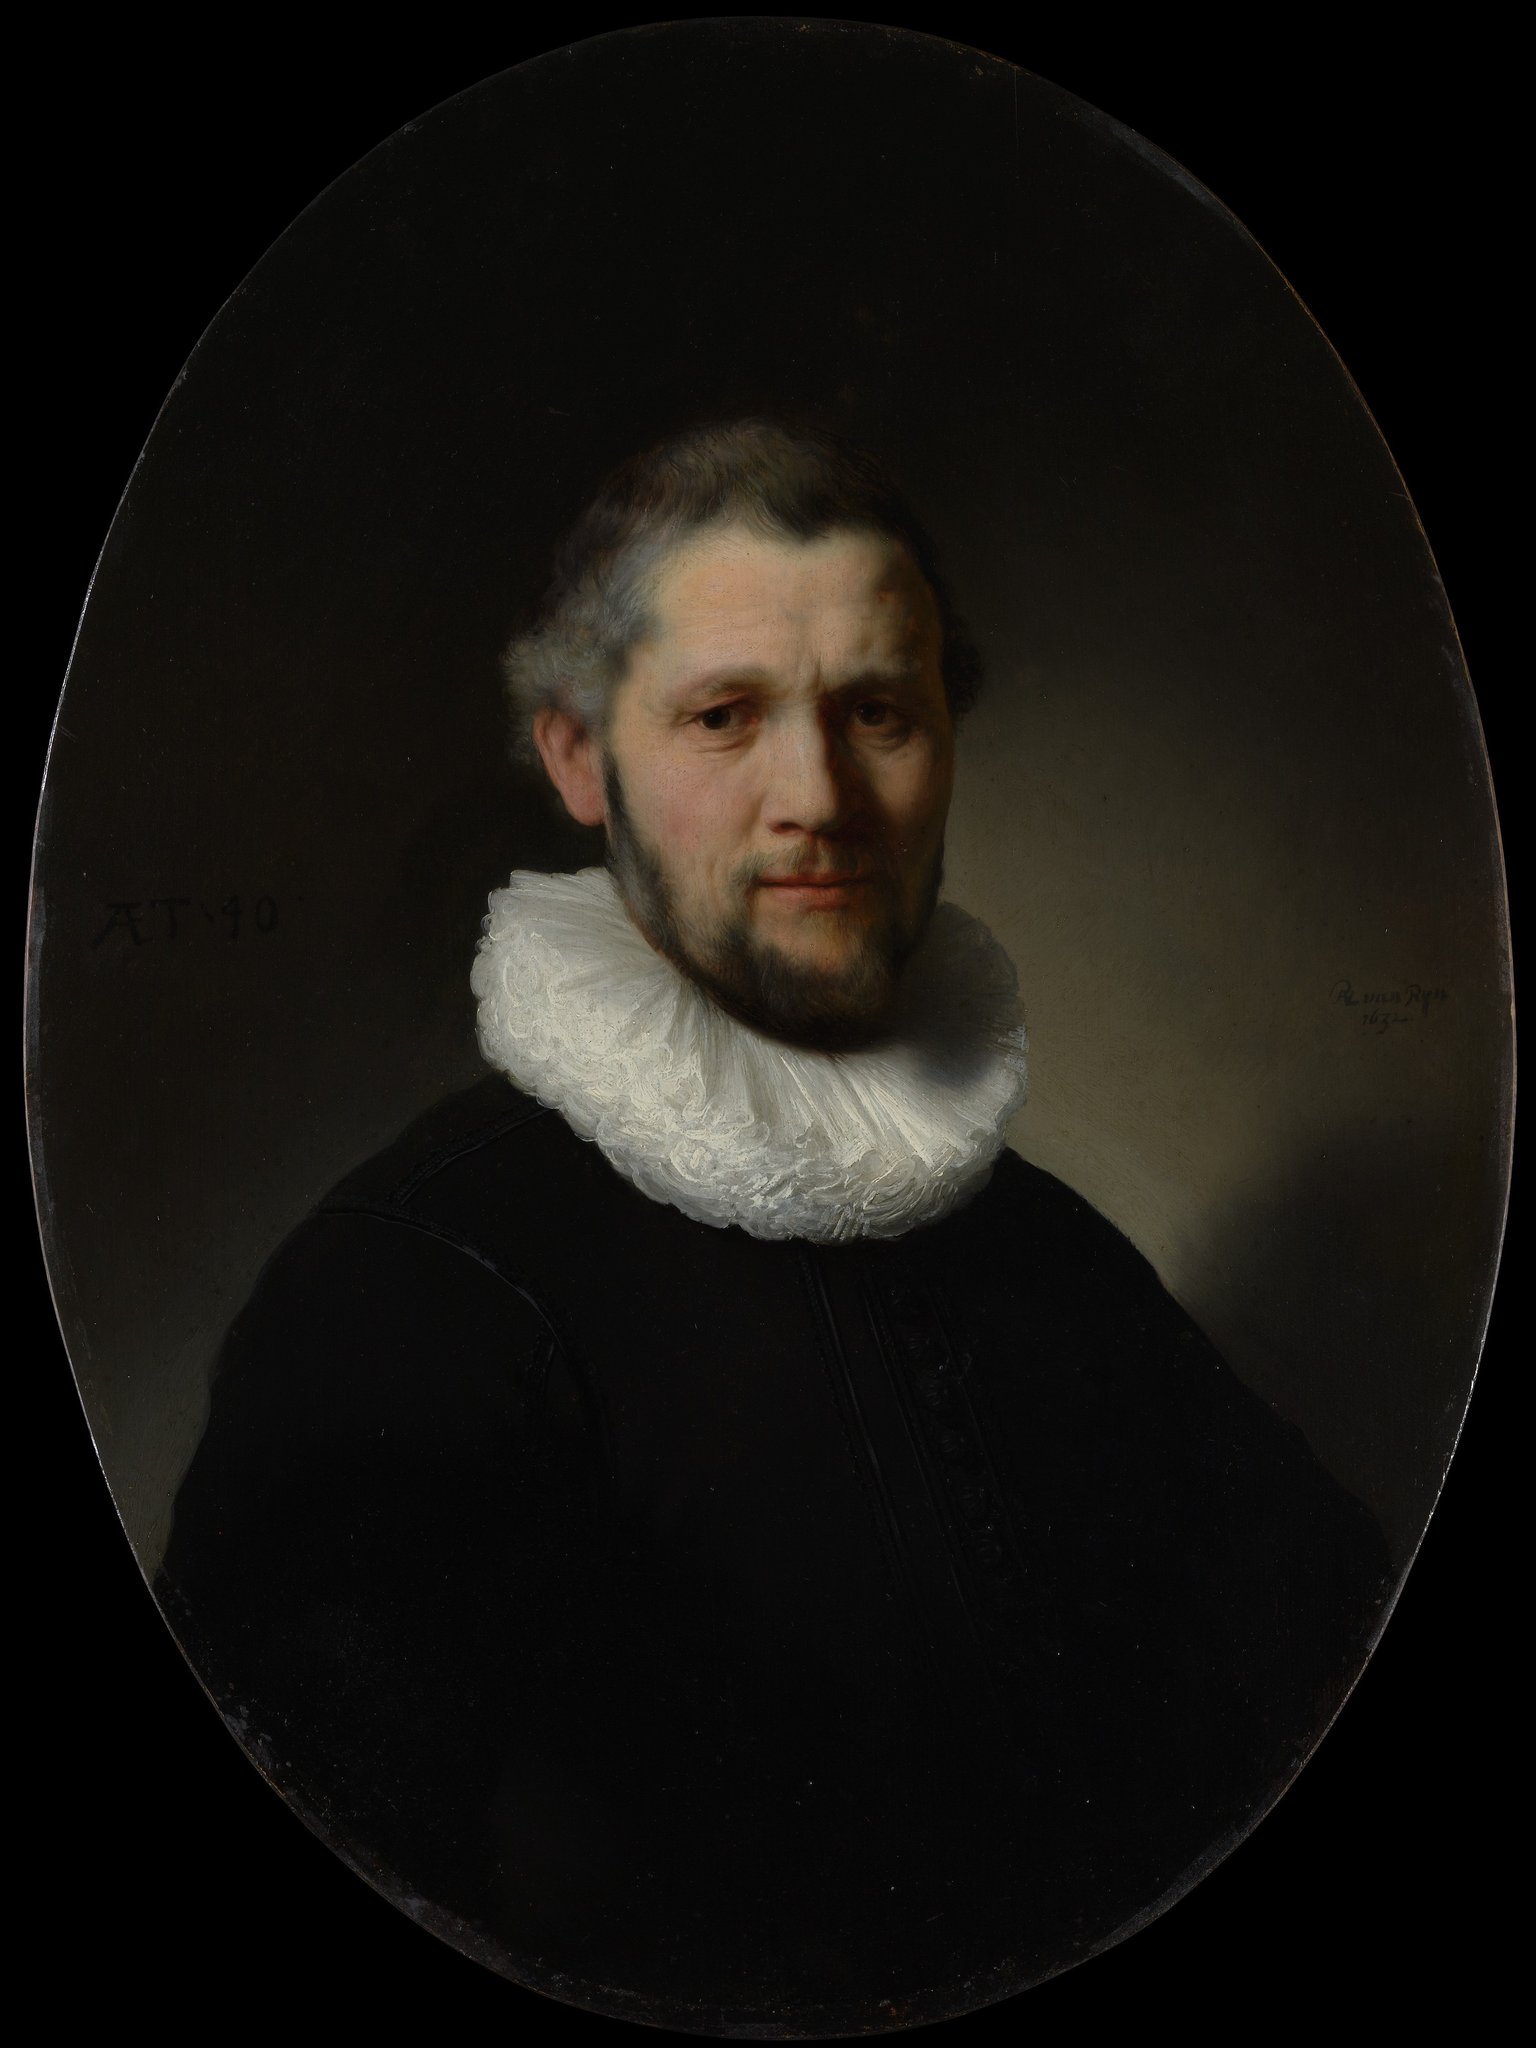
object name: painting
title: Portrait of a Man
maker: rembrandt van rijn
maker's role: artist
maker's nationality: dutch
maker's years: 1606-1669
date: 1632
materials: oil, wood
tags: men,portraits